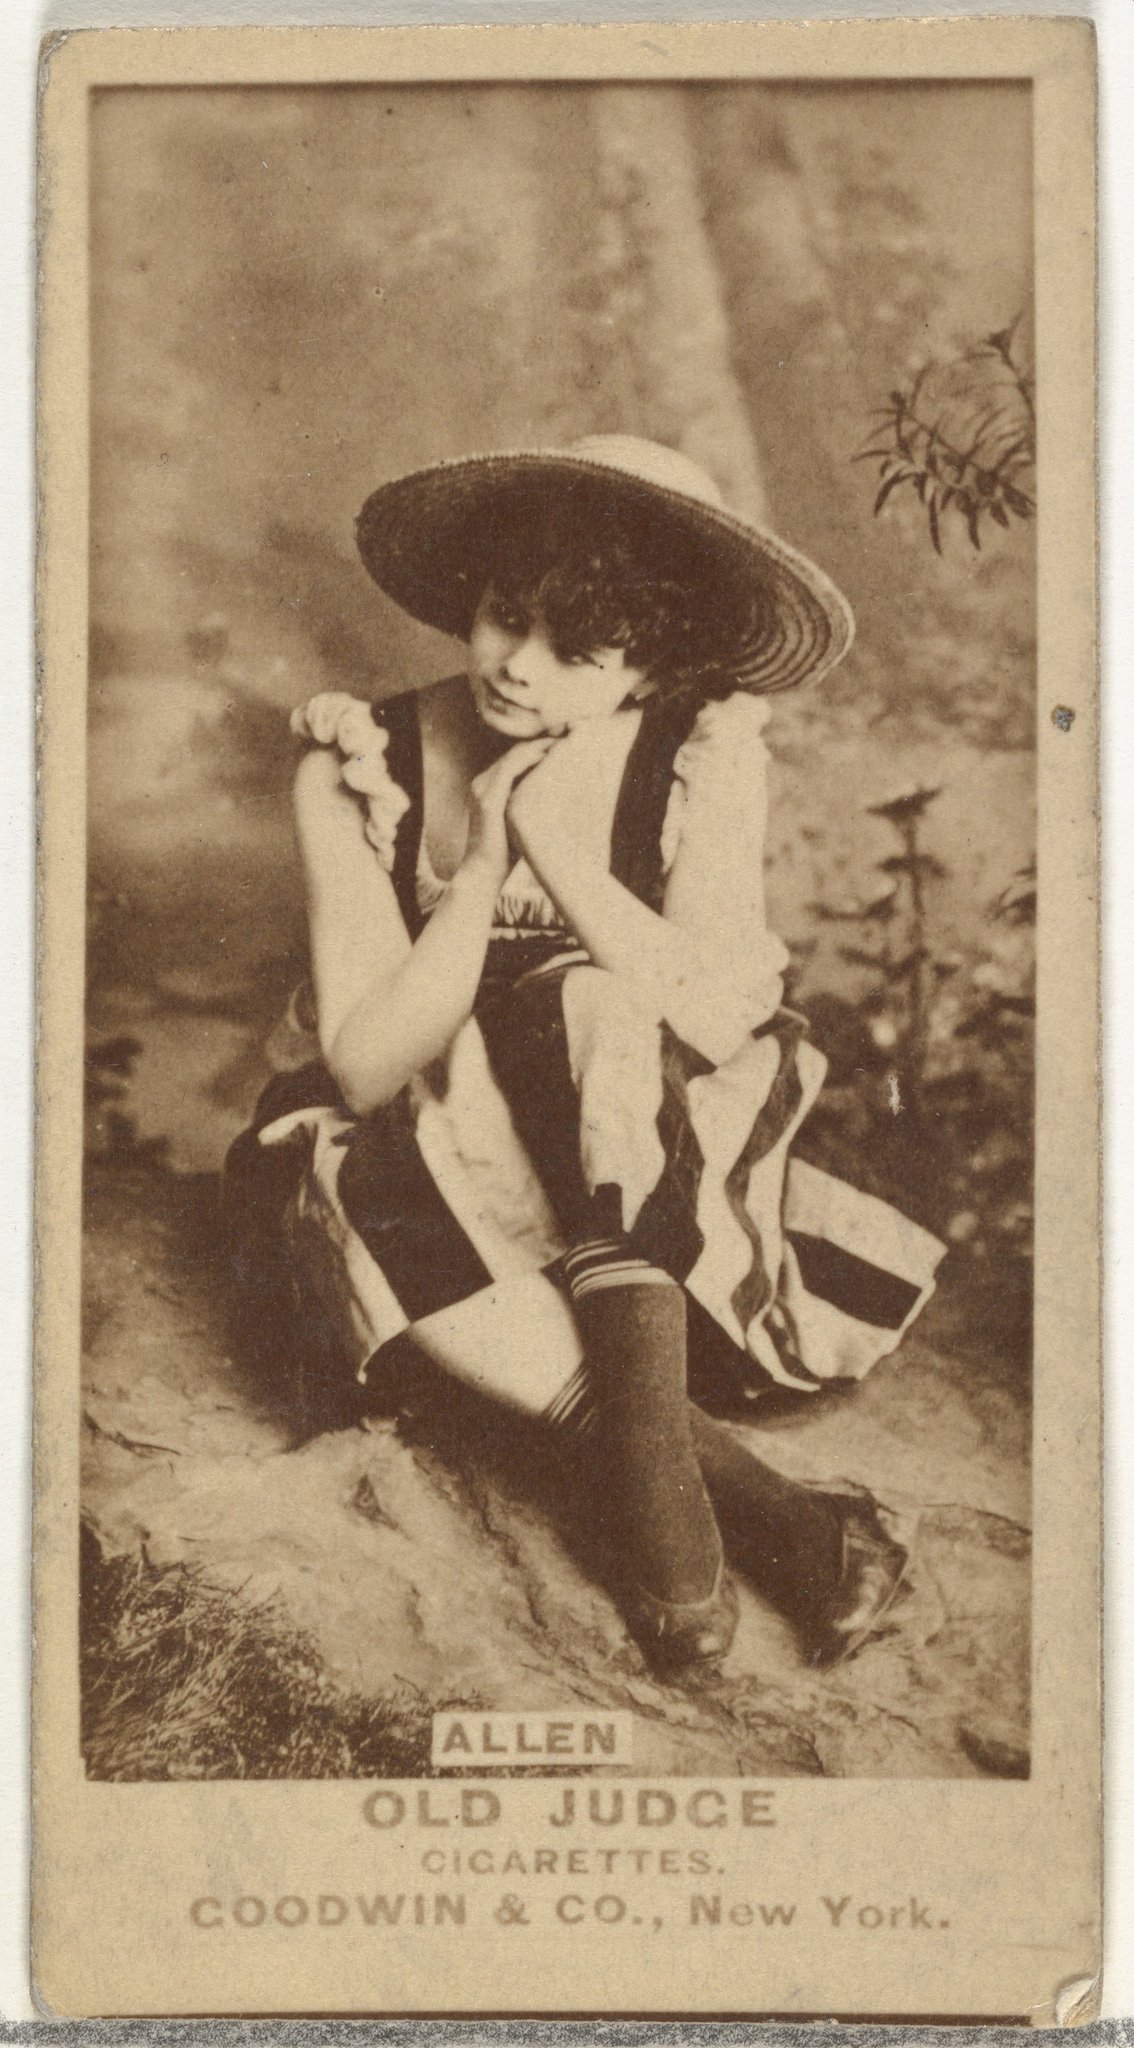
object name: photograph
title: Allen, from the Actors and Actresses series (N171) for Old Judge Cigarettes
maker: goodwin & company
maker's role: publisher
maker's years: 1850-1950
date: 1886-1890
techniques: albumen silver print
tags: portraits,women,actresses